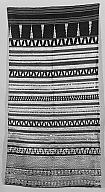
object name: skirt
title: Woman's Ceremonial Skirt (Tapis)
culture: lampung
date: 1801-1900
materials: cotton, gold, thread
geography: indonesia